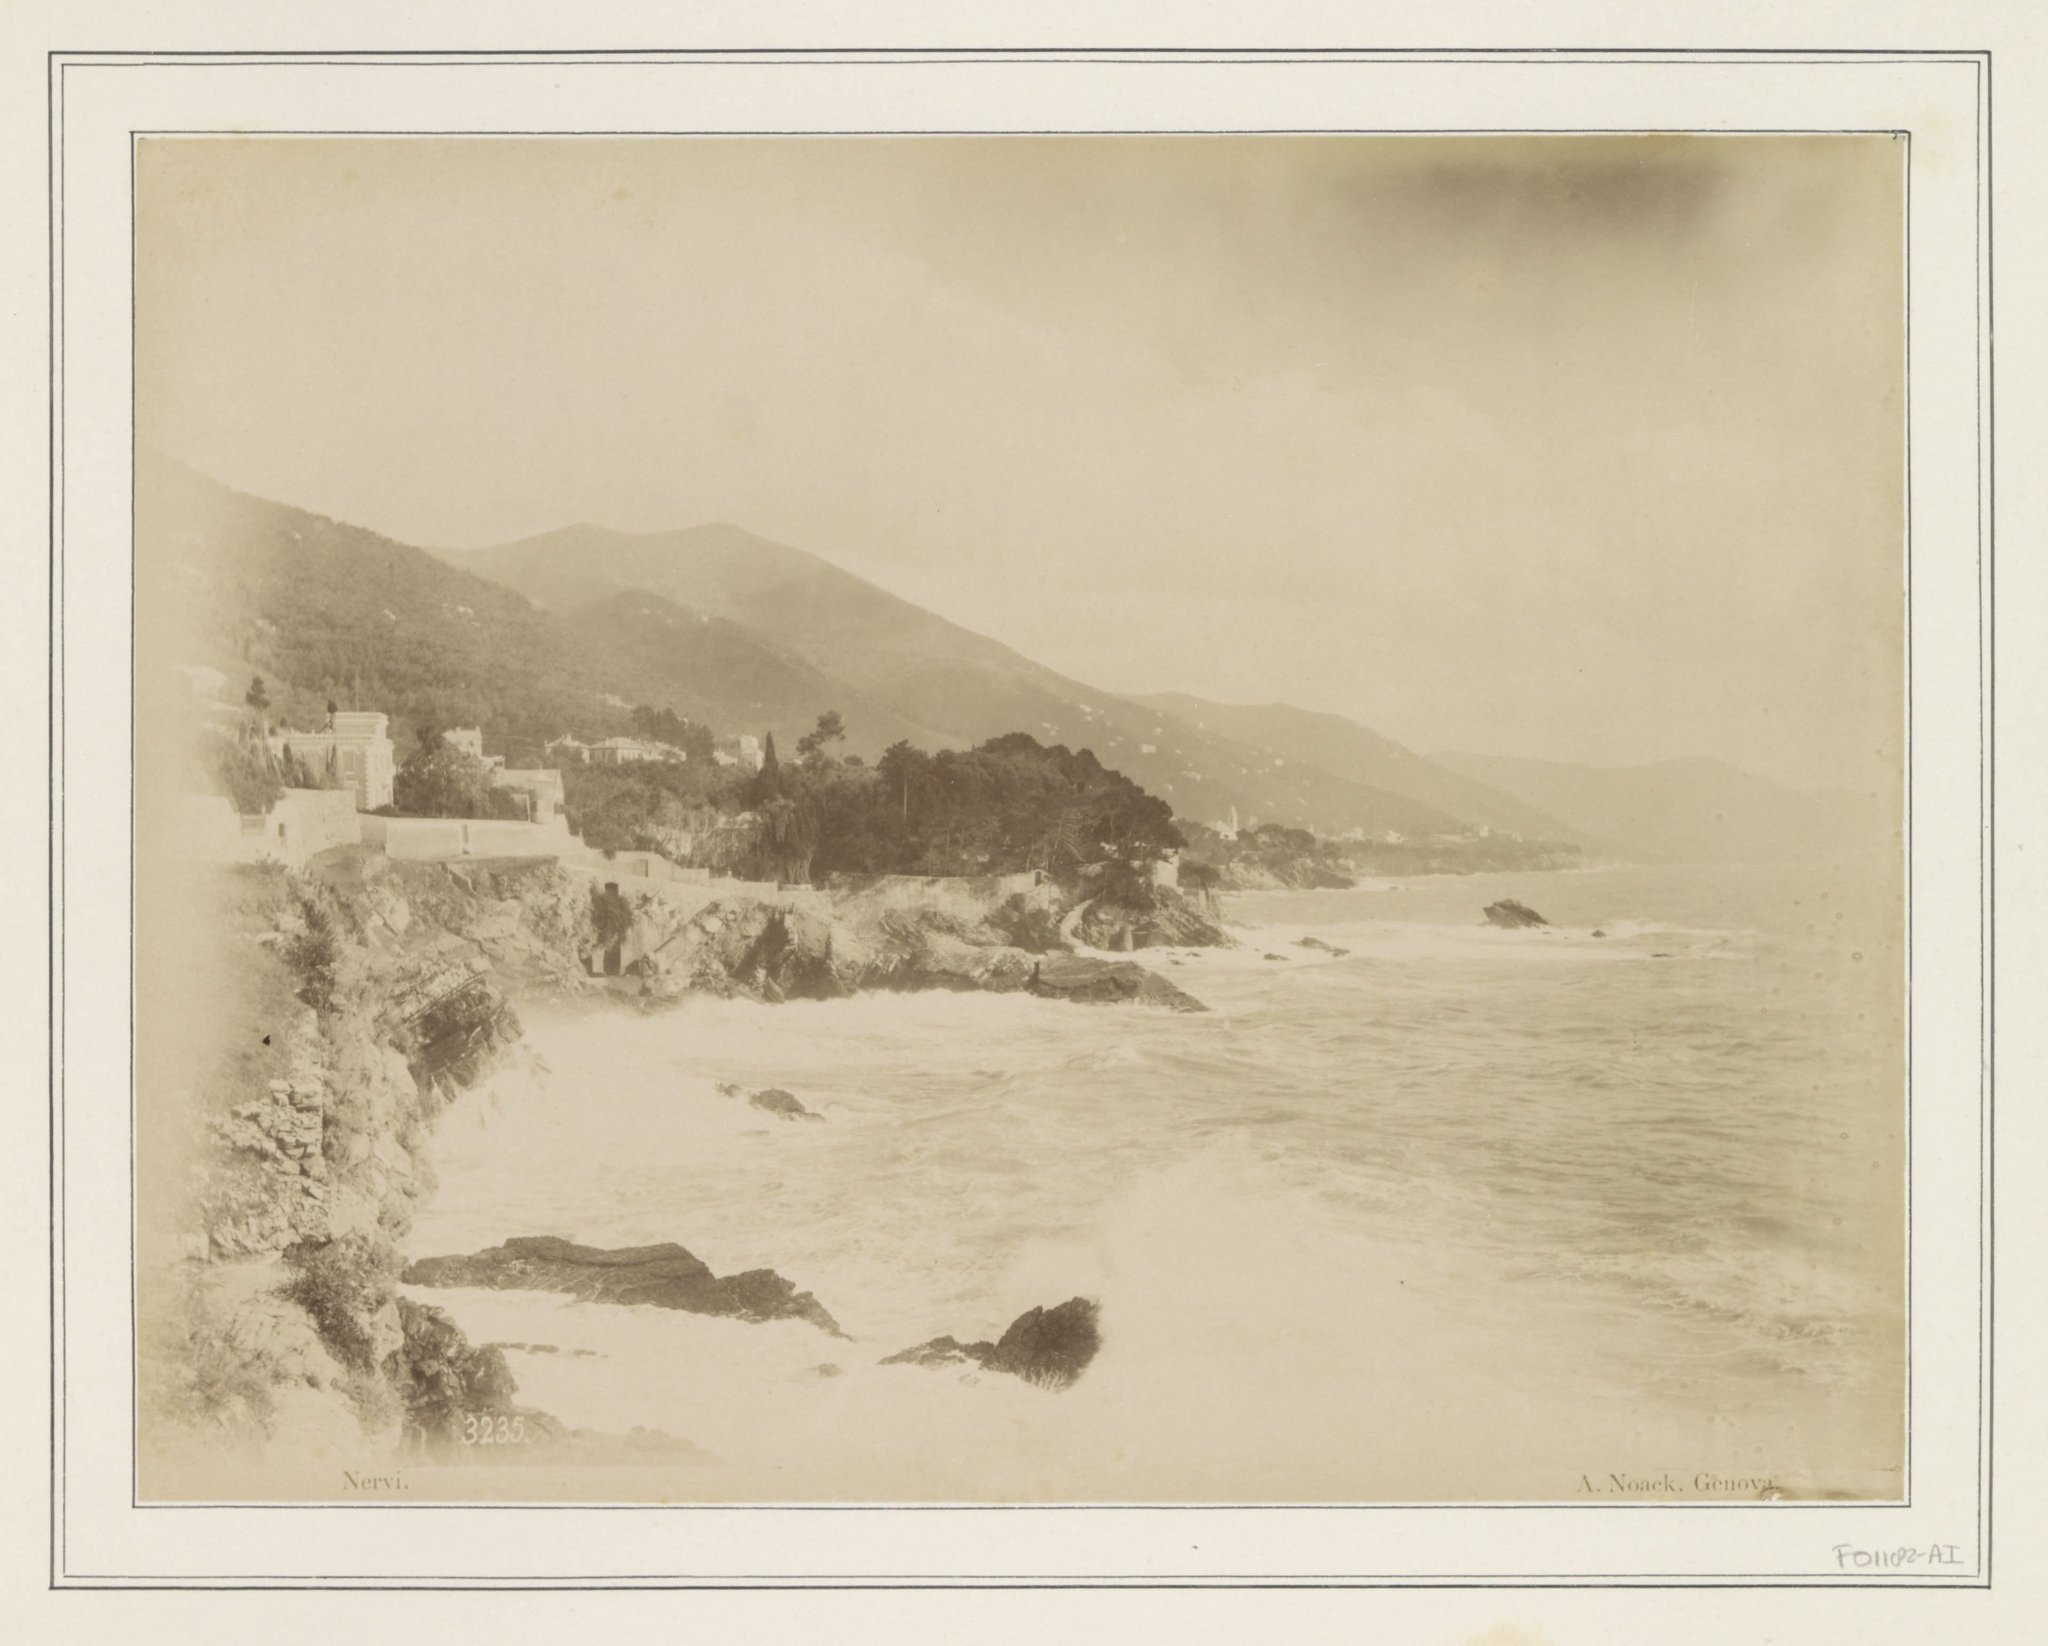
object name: photograph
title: Gezicht op de kust van Nervi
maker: alfredo noack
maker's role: fotograaf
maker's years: 1833-1895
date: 1860-1890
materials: paper, photographic support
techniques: albumen print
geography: nervi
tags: coast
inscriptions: negative number: ‘3235’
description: Onderdeel van Reisalbum met foto's van bezienswaardigheden in Italië en aan de Franse Rivièra (deel II).